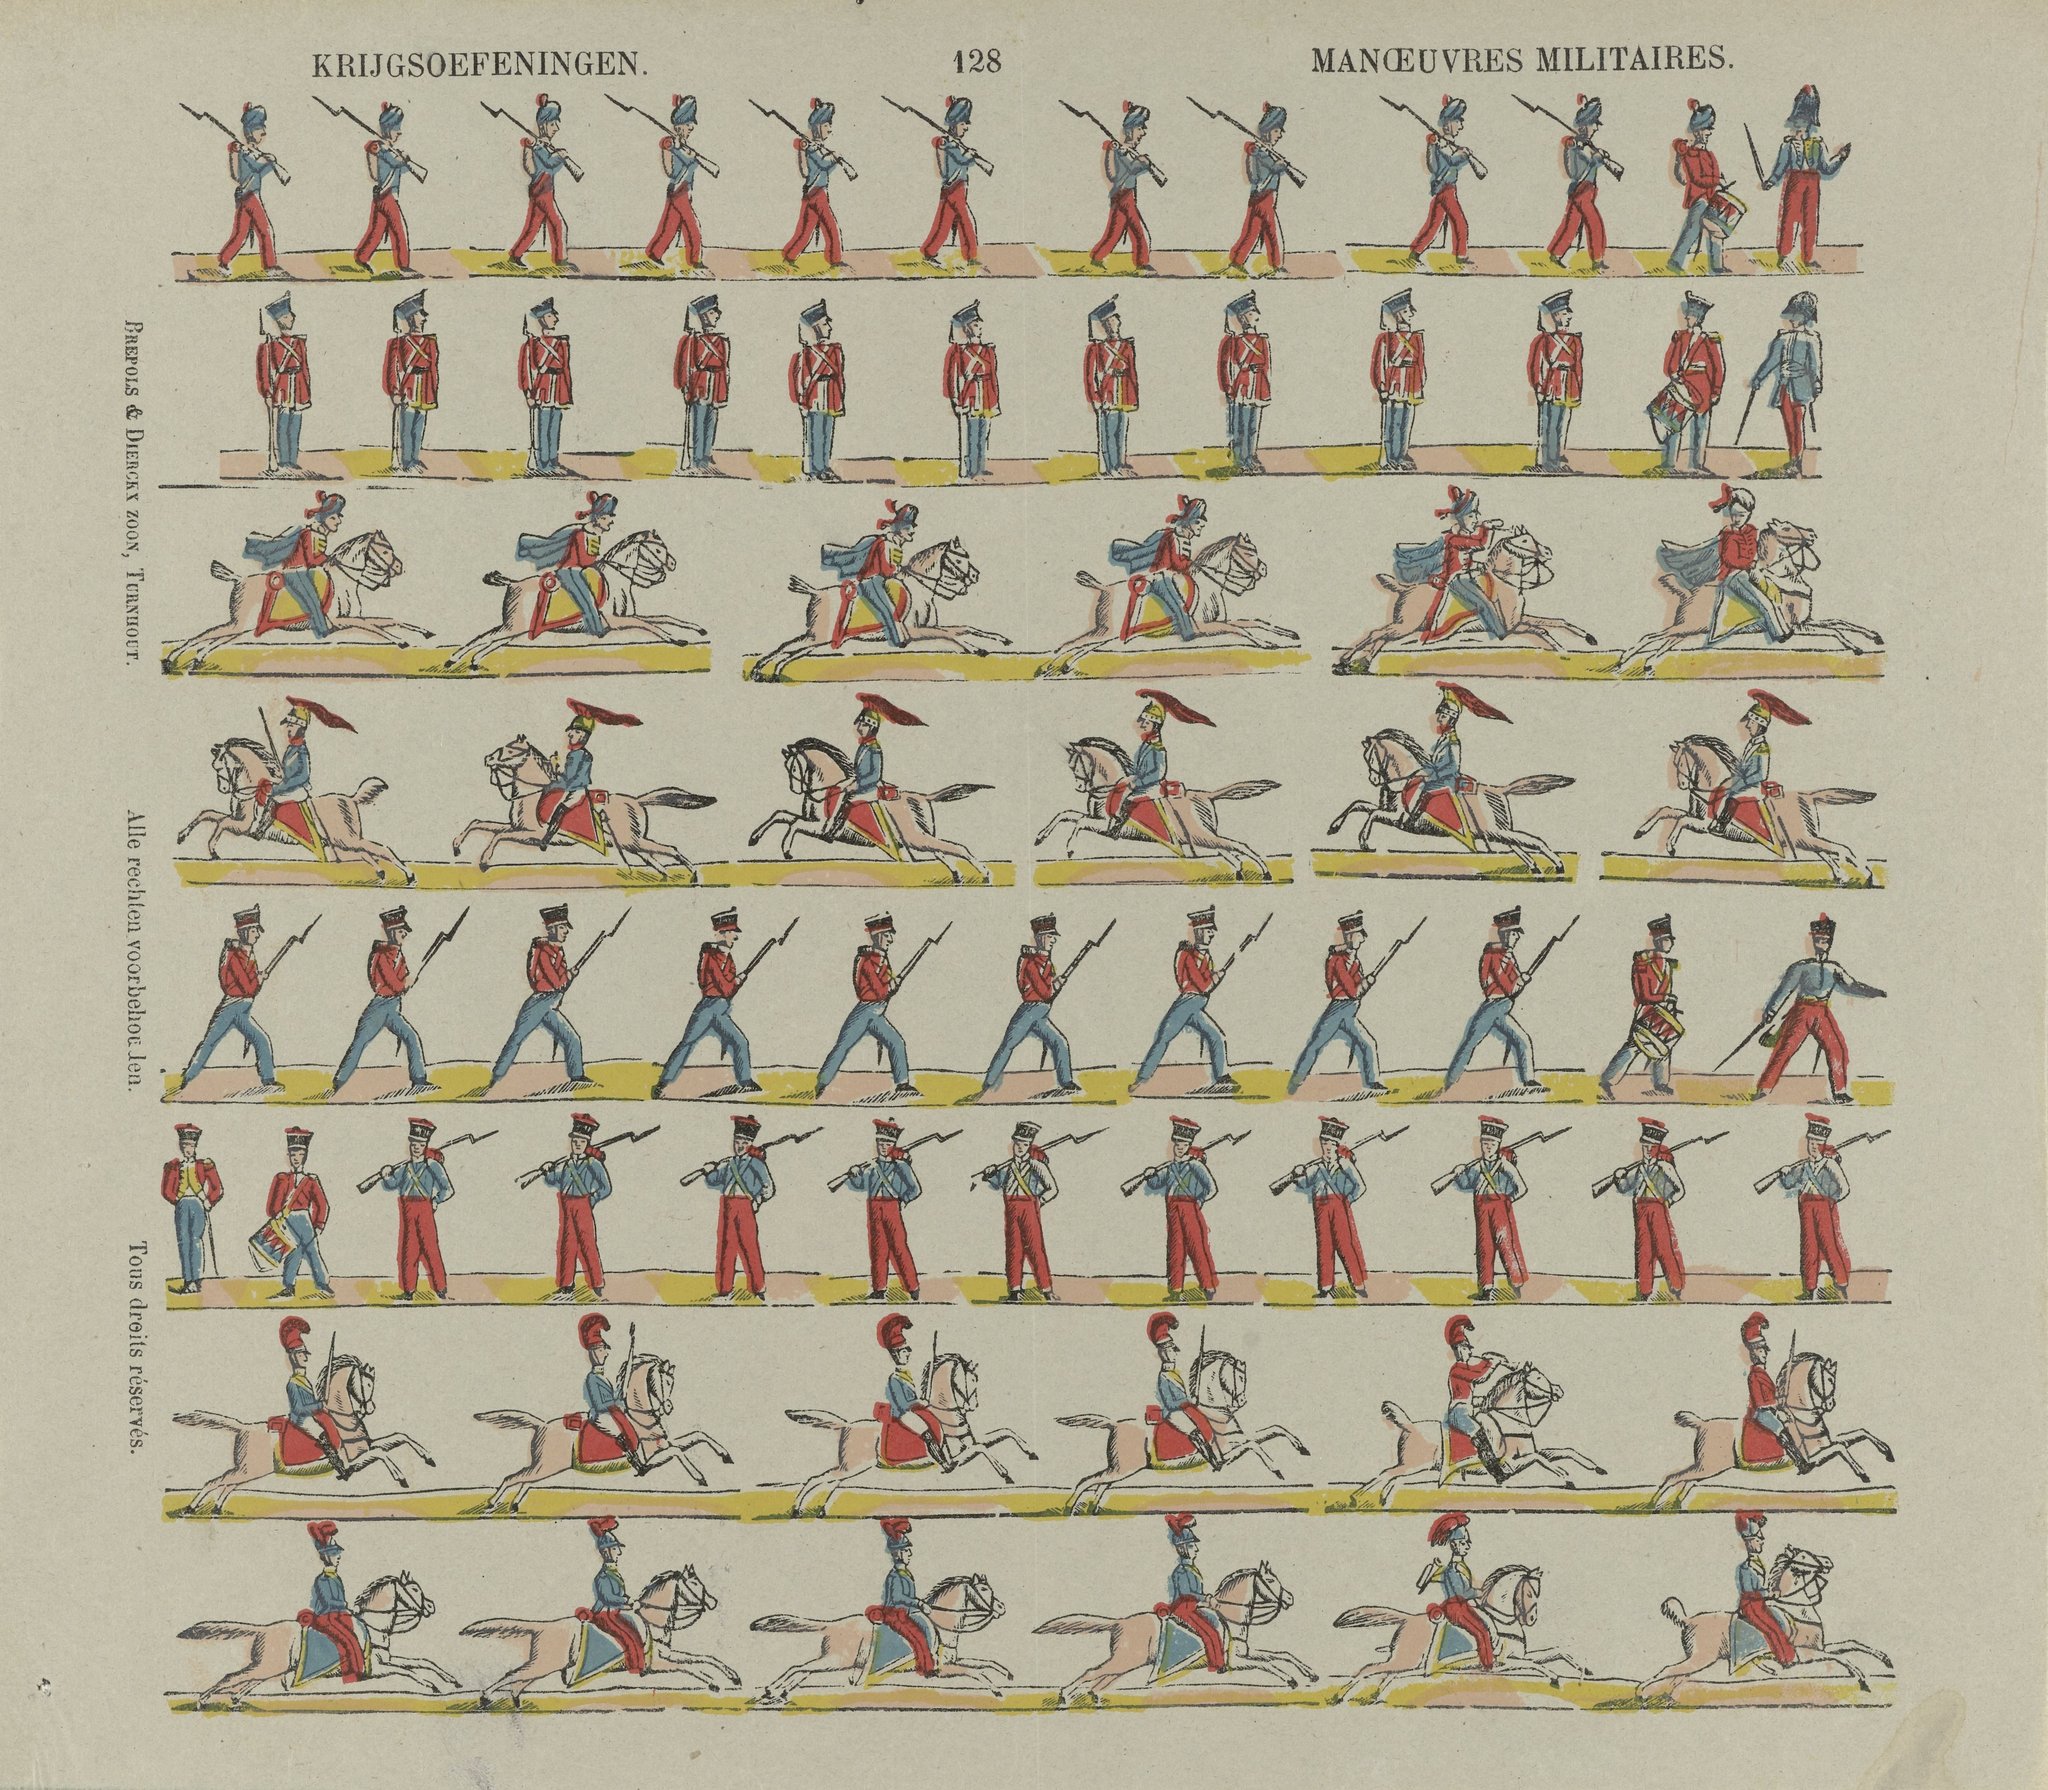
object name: print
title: Krijgsoefeningen / Manoeuvres militaires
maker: Anonymous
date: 1833-1911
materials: paper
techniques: lithograph, letterpress printing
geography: turnhout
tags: warfare; military affairs (+ cavalry, horsemen), the soldier; the soldier's life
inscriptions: collector's mark: Lugt 2760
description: Blad met 8 horizontale rijen met voorstellingen van militairen met wapens en militairen te paard. Genummerd midden boven: 128.